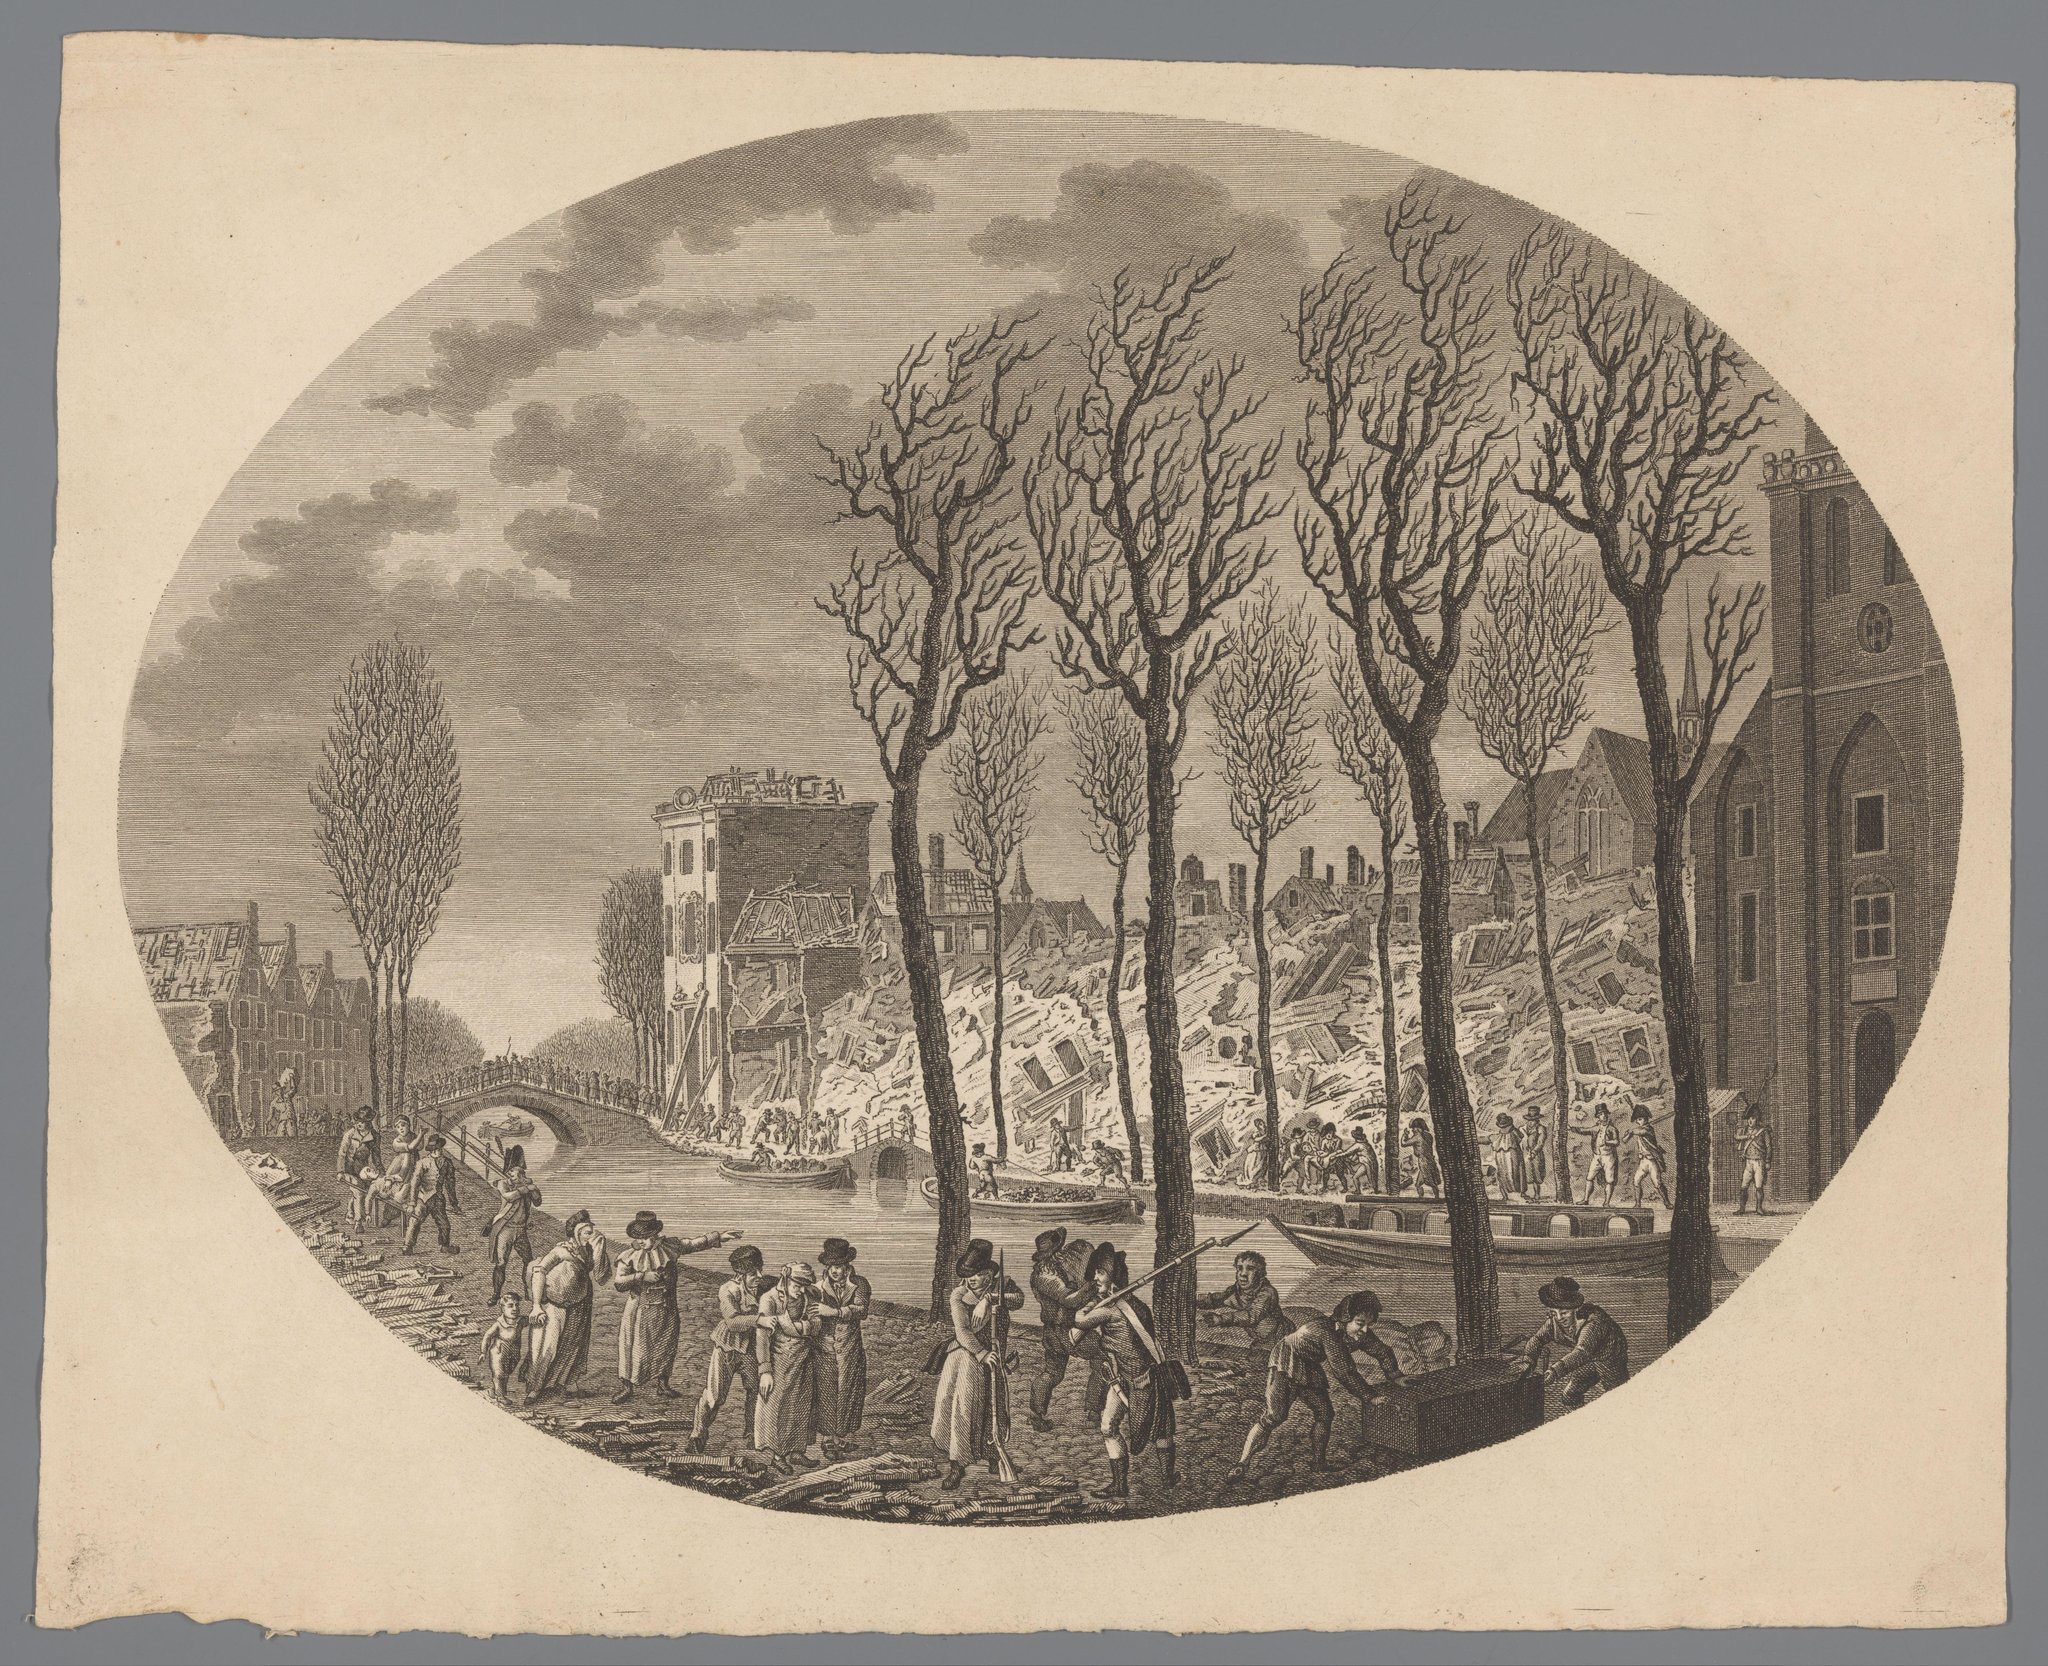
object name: print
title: Ruïnes te Leiden na de buskruitramp, 1807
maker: joannes bemme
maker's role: print maker, printer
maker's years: 1775-1841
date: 1807-1809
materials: paper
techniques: etching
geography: netherlands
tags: ruin of a dwelling, house, castle, etc., gunpowder disaster, street (+ city(-scape) with figures, staffage)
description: Ovale voorstelling van het verwoeste gebied aan de noordzijde op het Steenschuur met de Saaihal te Leiden na de buskruitramp op 12 januari 1807.